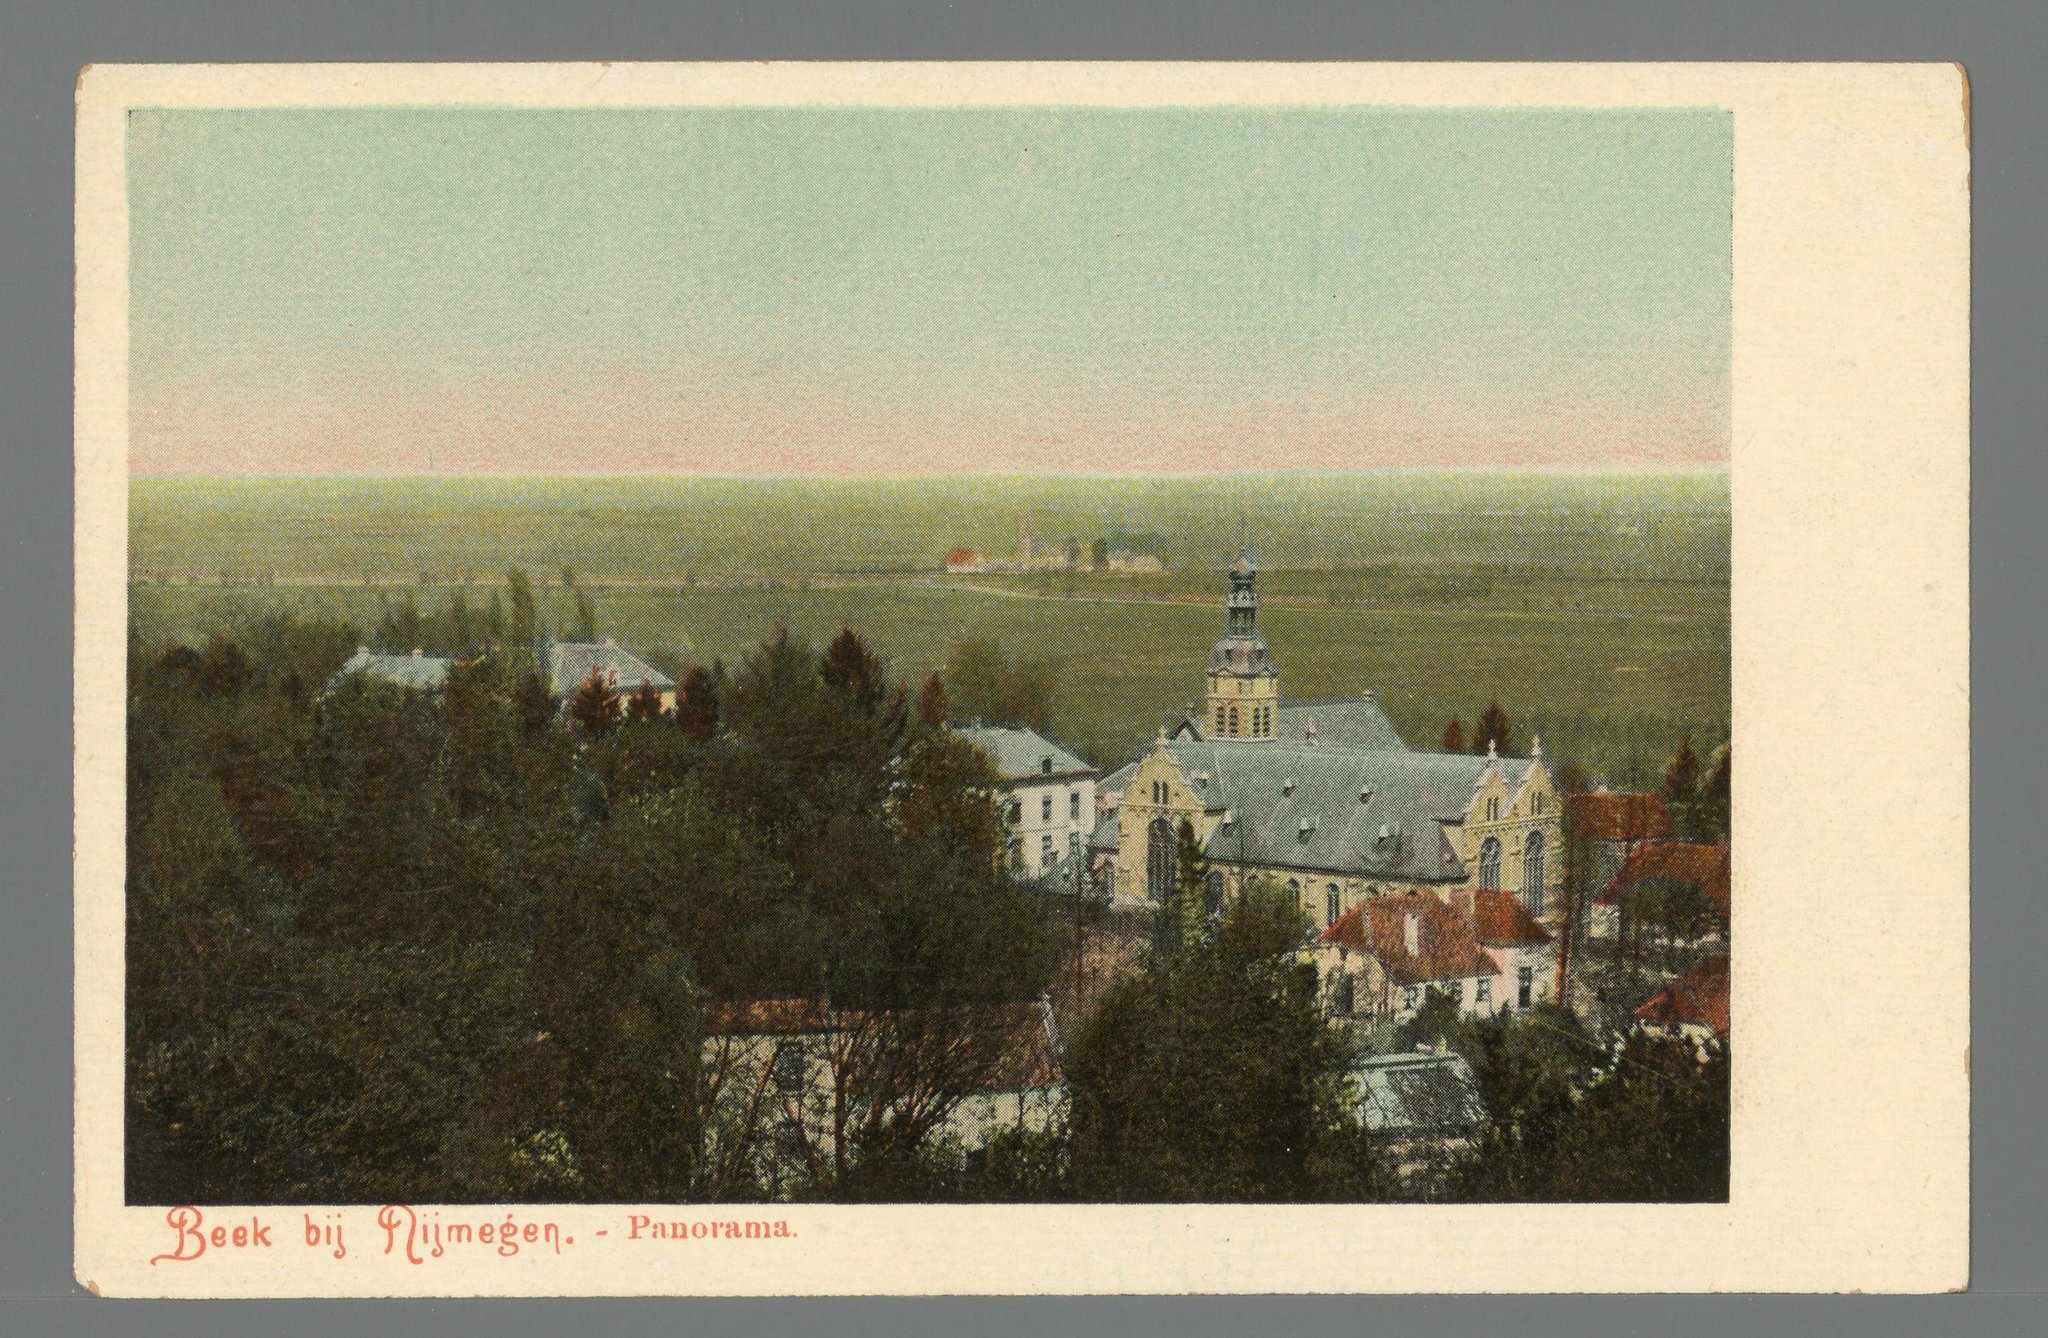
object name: ansichtkaart, prentbriefkaart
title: Beek bij Nijmegen. - Panorama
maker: Anonymous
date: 1905-1930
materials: cardboard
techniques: lithograph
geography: beek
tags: church (exterior), prospect of city, town panorama, silhouette of city